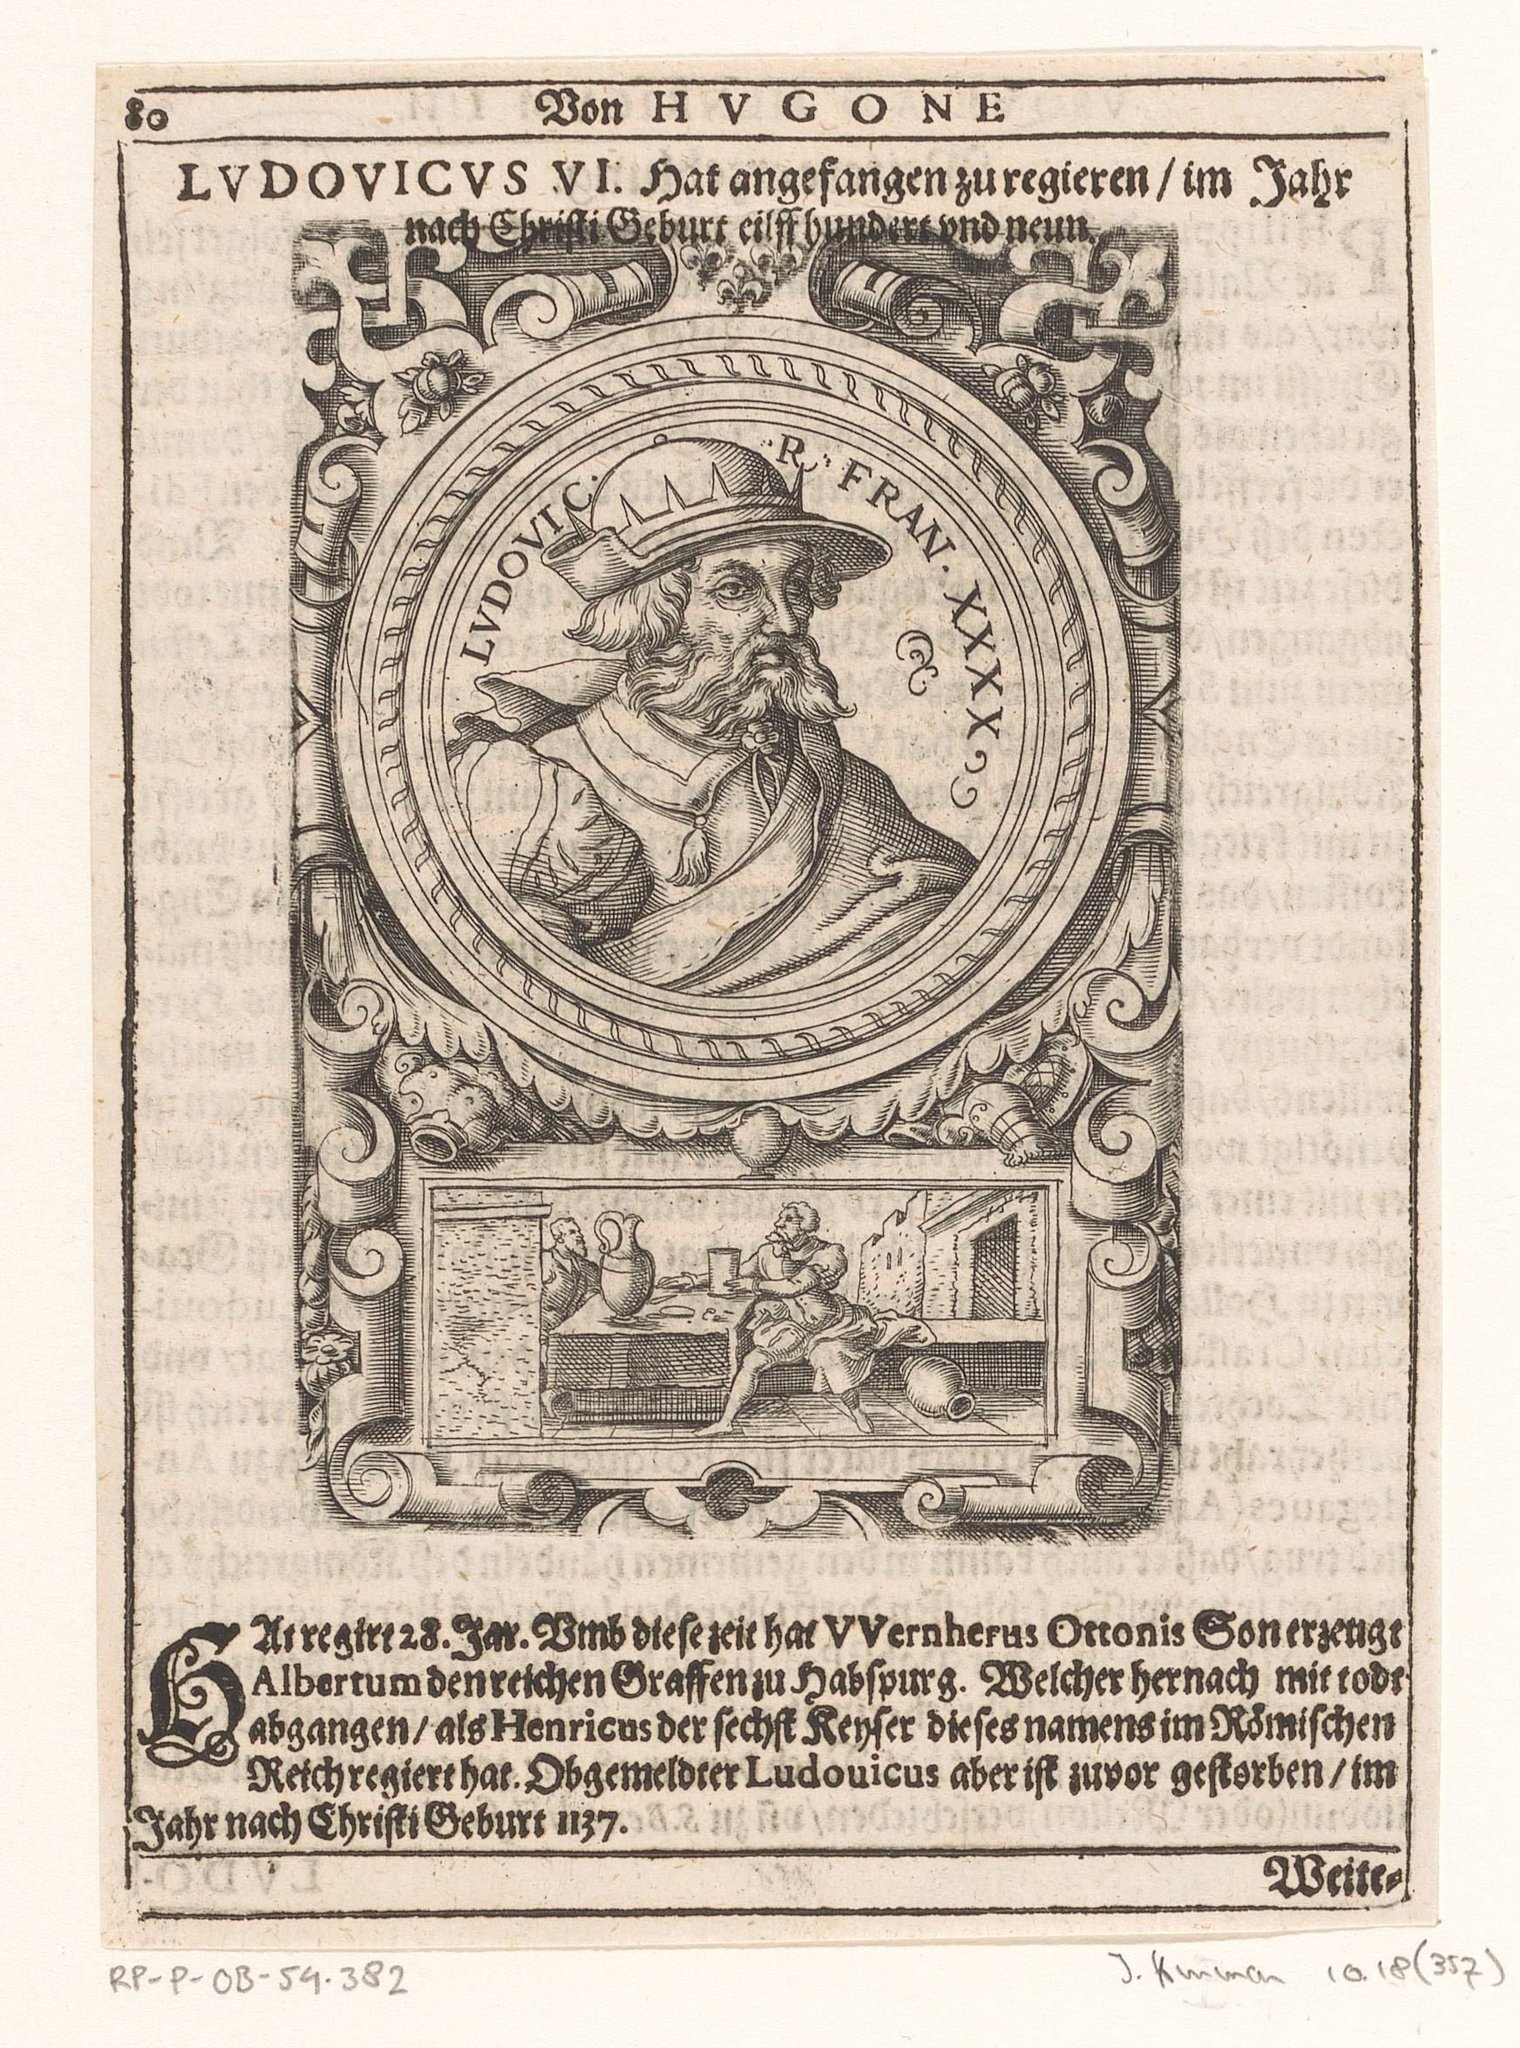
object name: book illustration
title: Portret van Lodewijk VI, koning van Frankrijk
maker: johann bussemacher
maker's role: print maker, printer, publisher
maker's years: -1627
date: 1598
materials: paper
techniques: engraving, etching, intaglio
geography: nuremberg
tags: paris, scrollwork, strapwork ~ ornament, historical persons, ruler, sovereign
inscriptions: collector's mark: Lugt 2228, number: ‘158’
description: Prent afkomstig uit de publicatie: Michael Eizinger. Könige in Frankreich. Keulen: Johann Bussemacher, 1598, p. 80. De publicatie bevat prenten van Jost Amman en Virgil Solis.